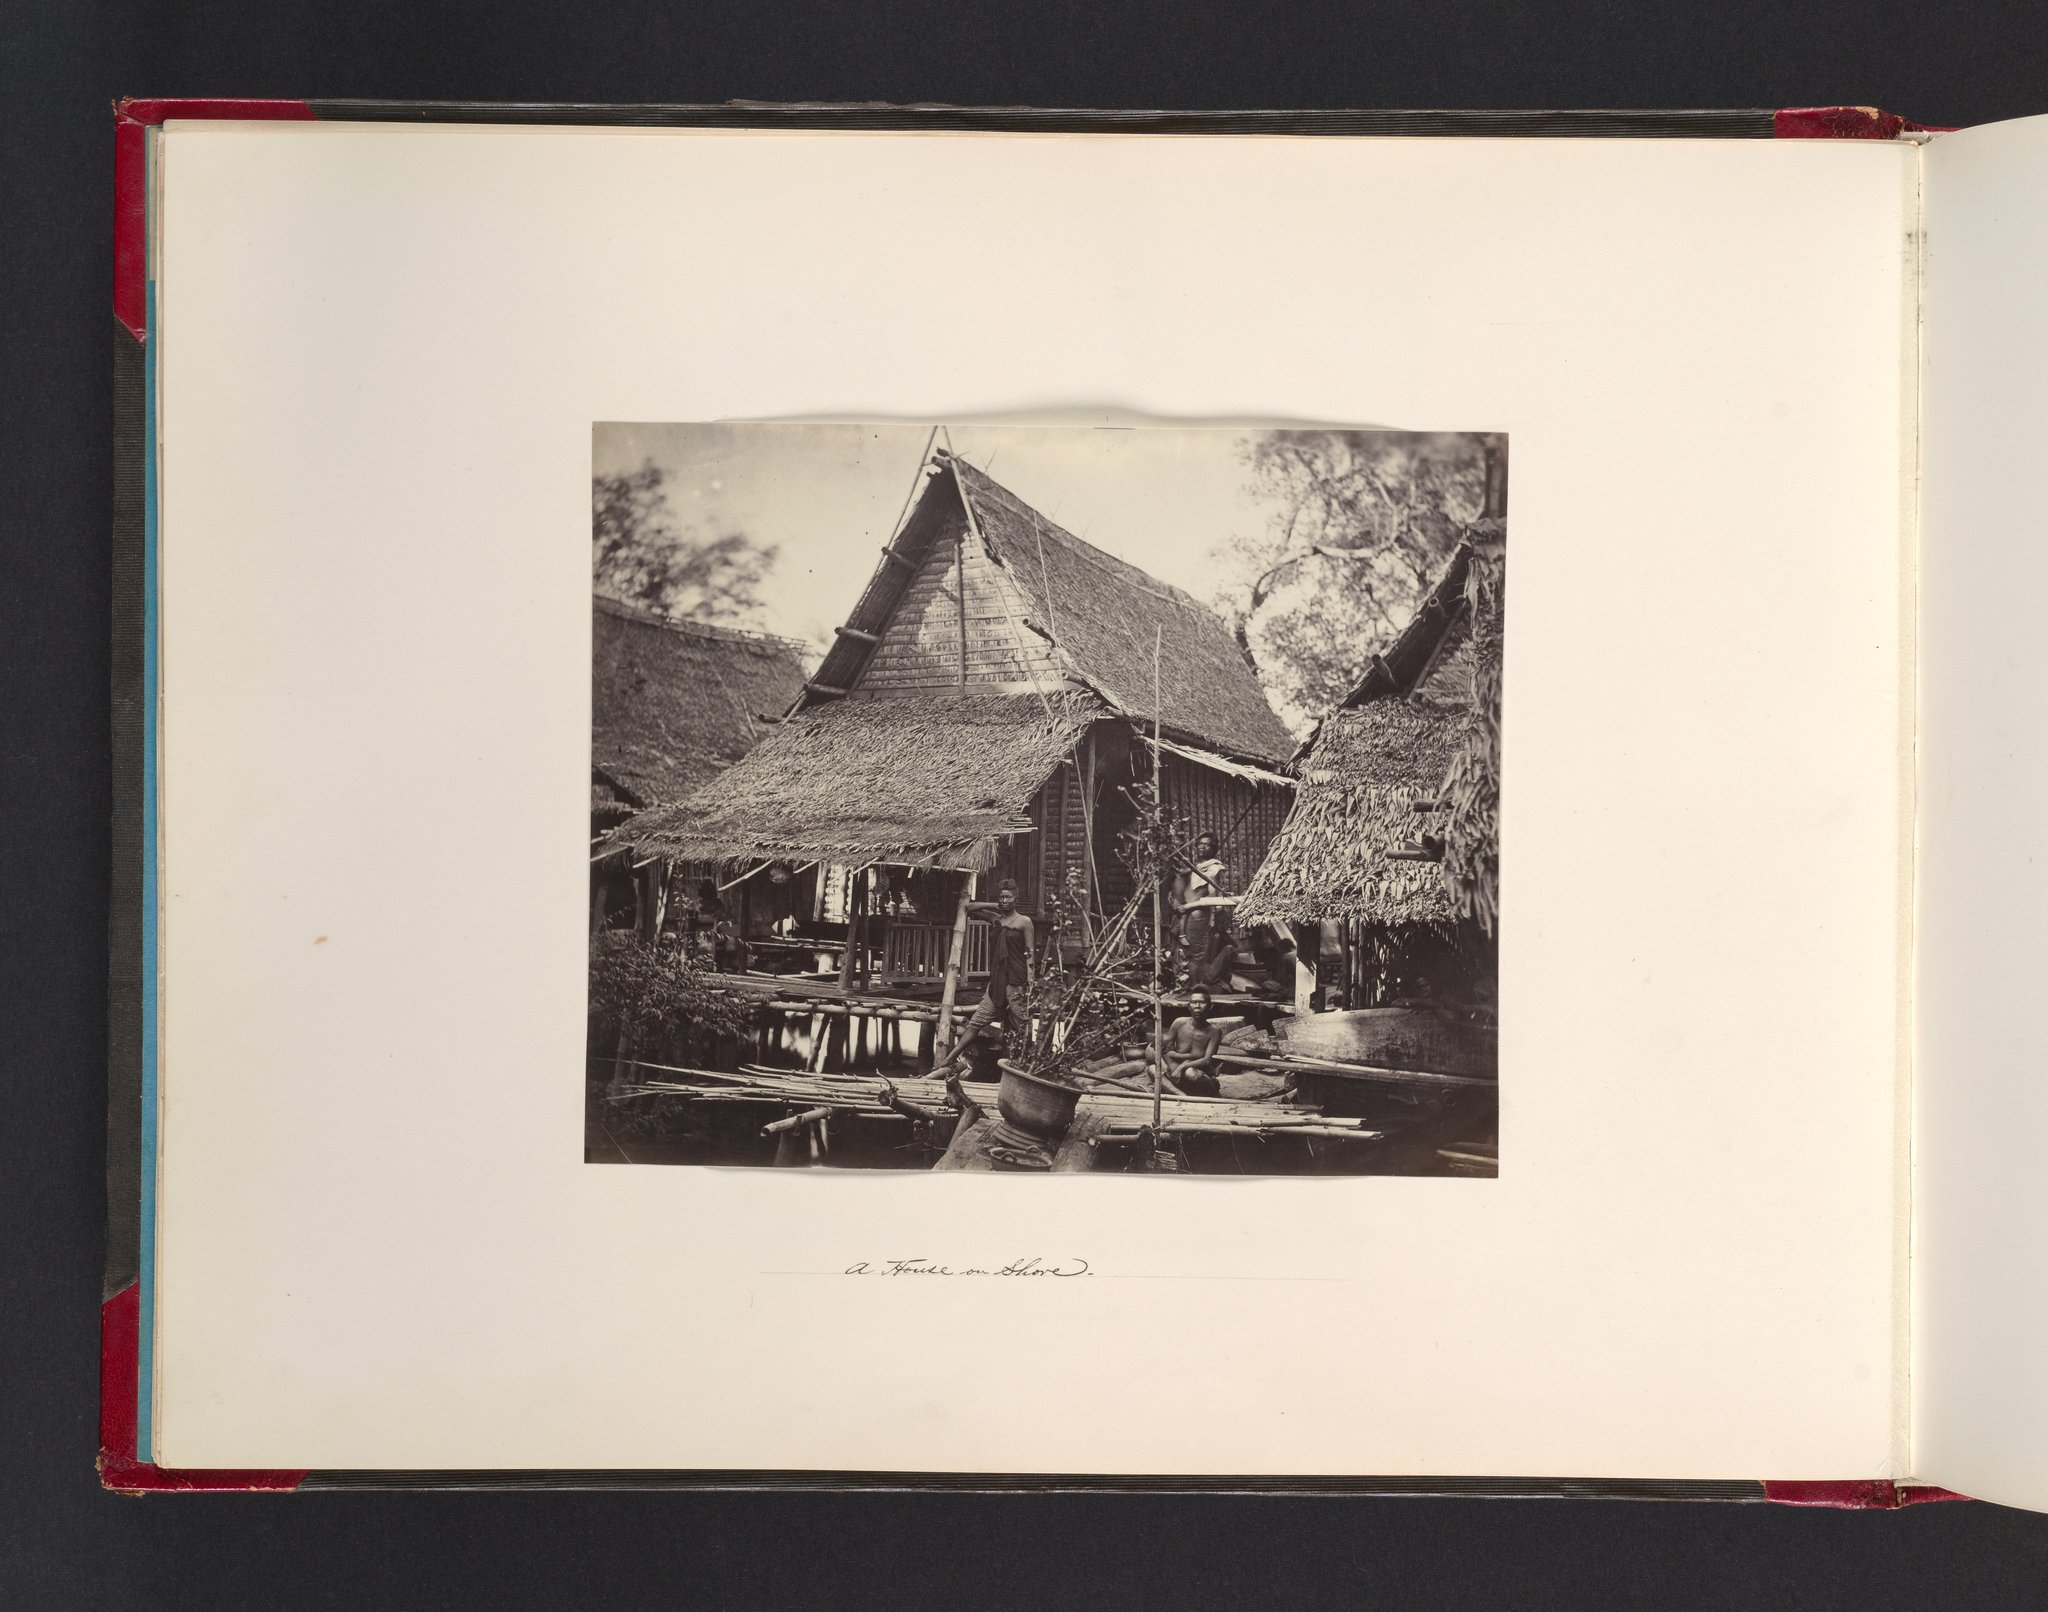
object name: photograph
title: A House on Shore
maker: john thomson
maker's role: artist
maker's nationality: british, scottish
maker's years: 1837-1921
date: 1865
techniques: albumen silver print, glass negative